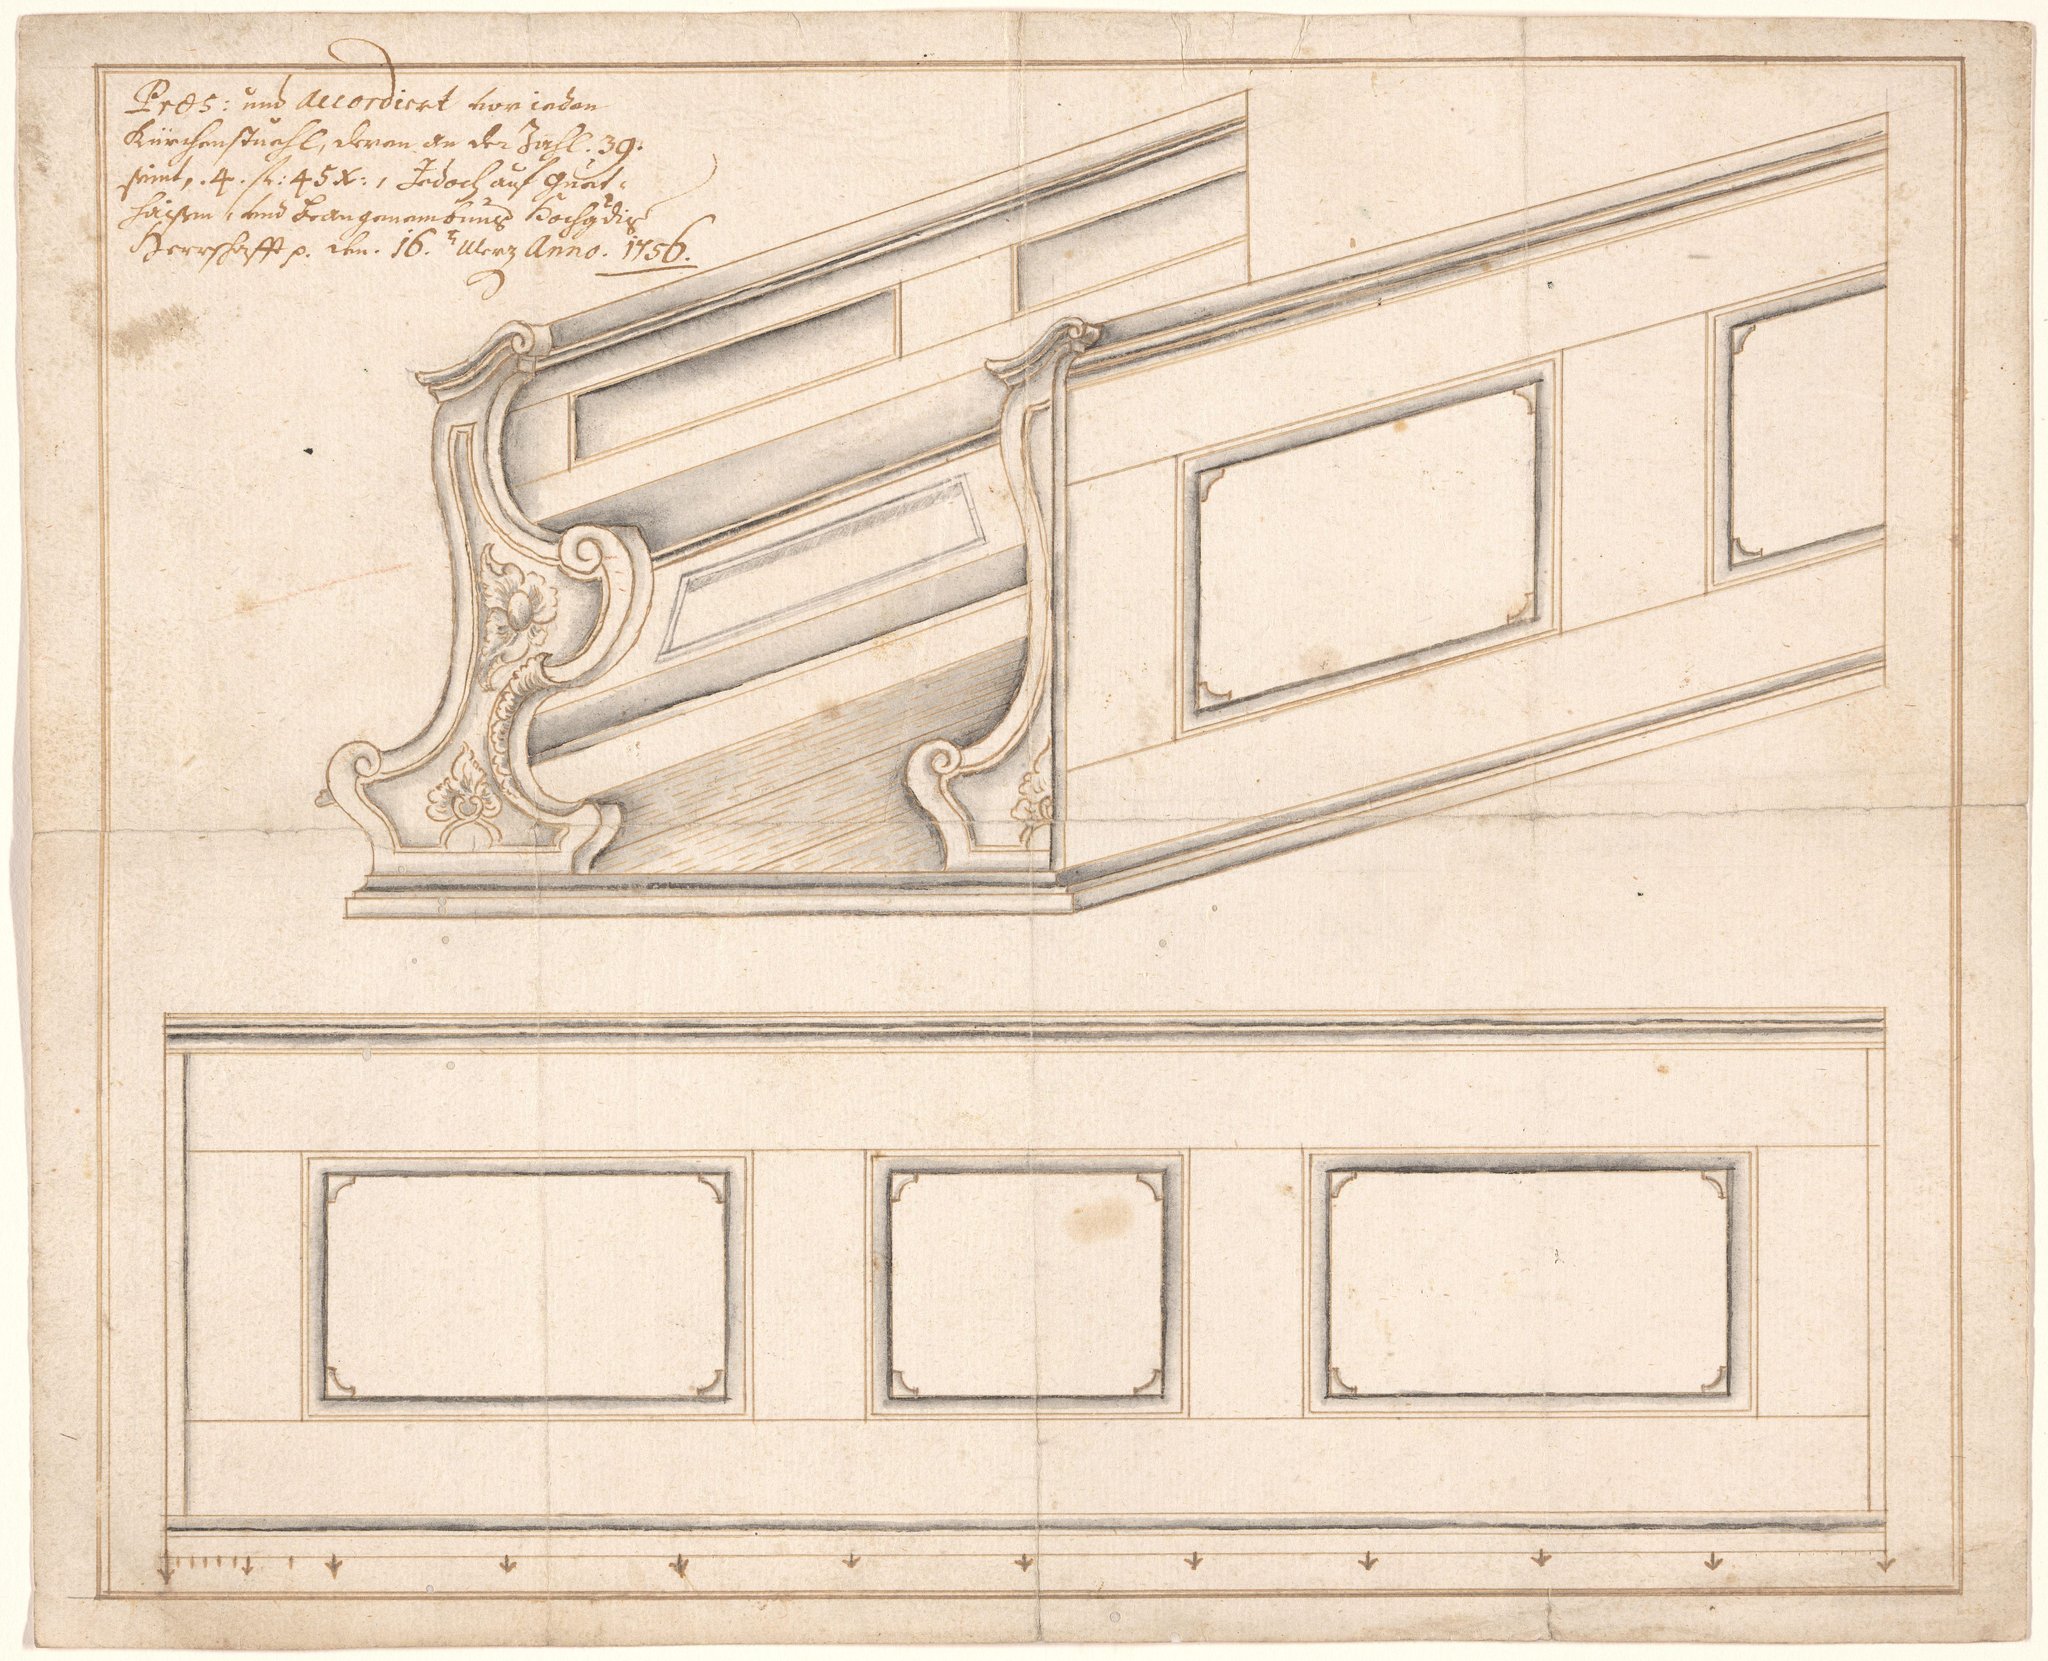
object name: drawing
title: Ontwerp voor een kerkgestoelte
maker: Anonymous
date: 1756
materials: graphite, ink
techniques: brush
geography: germany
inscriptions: inscription: ‘Pros: und accordiret kor inden Kürchenstühl, deren an der Zahl. 39. sint, .4. [?]: 45x:, Jedoch auf Guat-heissen, und Bangemombung [??] hochg’dig Herrschaft p. den 16.tr Merz Anno. 1756. [?]’